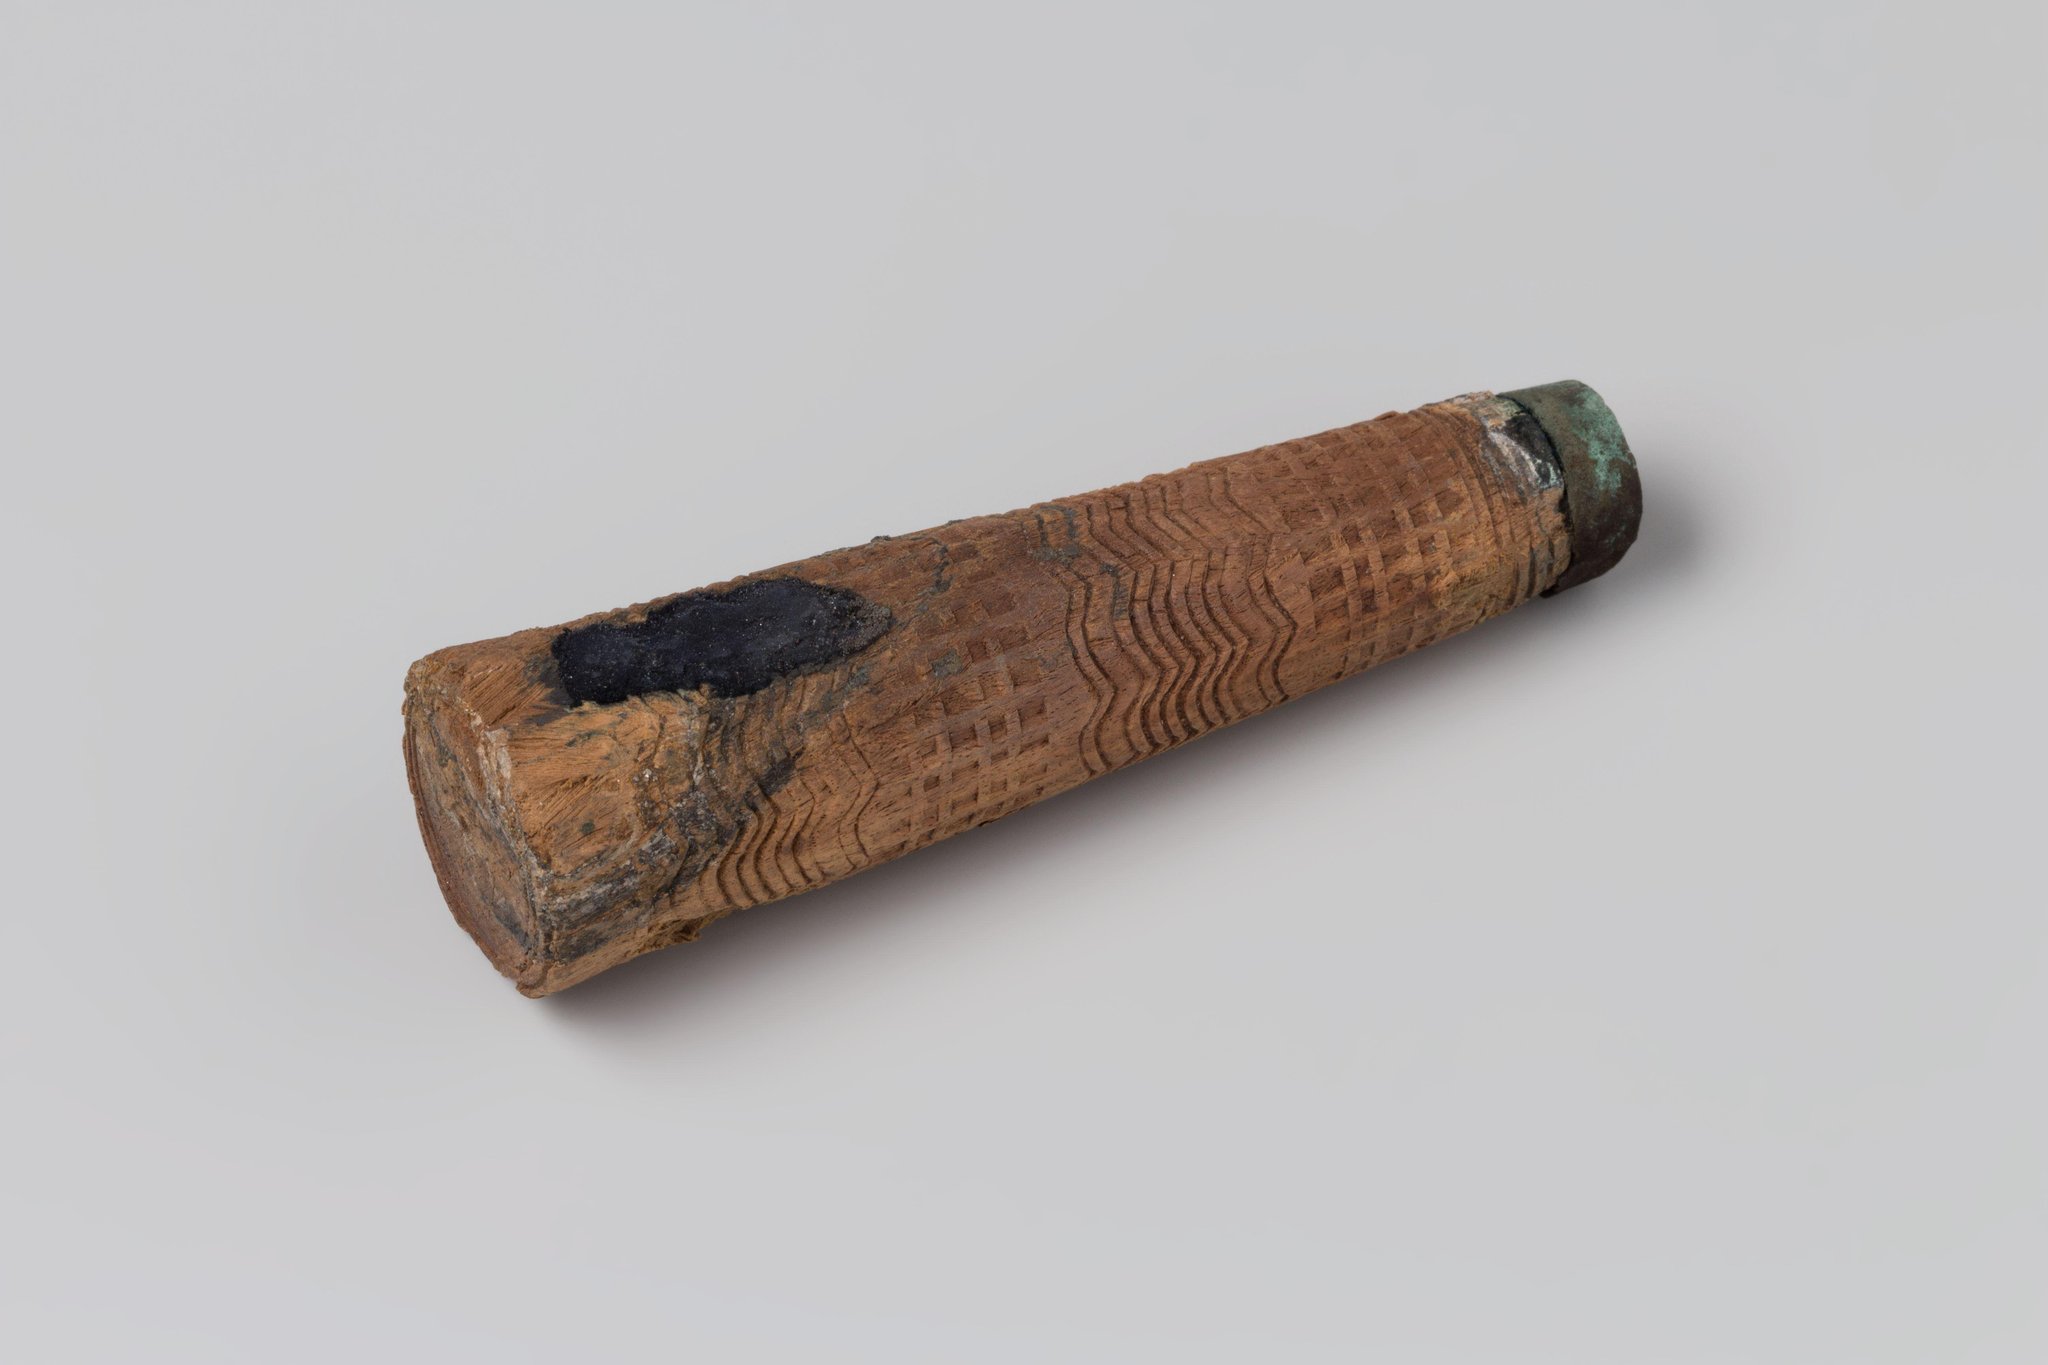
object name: knife handle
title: Messenheft uit het wrak van de Oost-Indiëvaarder Hollandia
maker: Anonymous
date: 1700-1743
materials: copper, wood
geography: netherlands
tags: verenigde oostindische compagnie, hollandia (schip), annet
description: Knife, handle, cylindrical: tapering; id. NG 1979-403H, ferrule, id. NG 1980-27H426.